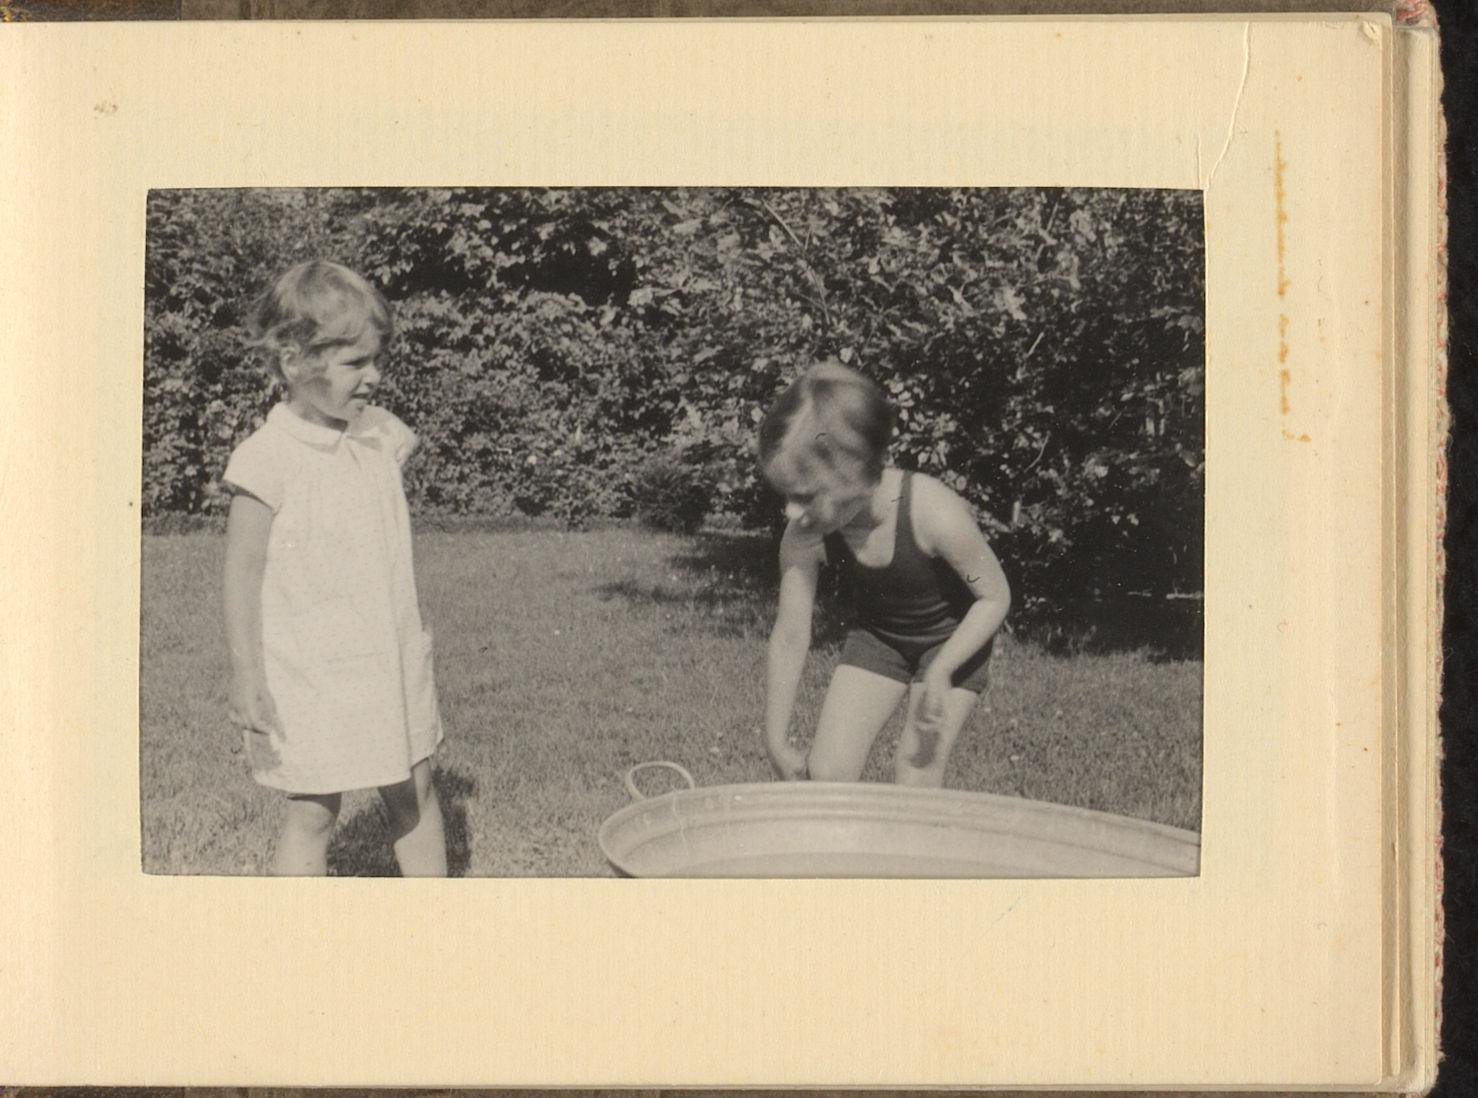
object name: album leaf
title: Isabel Wachenheimer rond een tobbe met een onbekend meisje, juli-augustus 1933, Hamburg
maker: else wachenheimer-moos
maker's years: 1895-1944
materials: paper, photographic support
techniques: gelatin silver print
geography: hamburg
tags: leiden, isabel wachenheimer-elon, the family travelling, on holiday, children's games and plays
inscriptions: date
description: Albumblad bevat een foto van Isabel Wachenheimer (met donker badpak) en onbekend meisje (in lichte jurk). Onderdeel van het fotoalbum Hamburg zomer 1933.